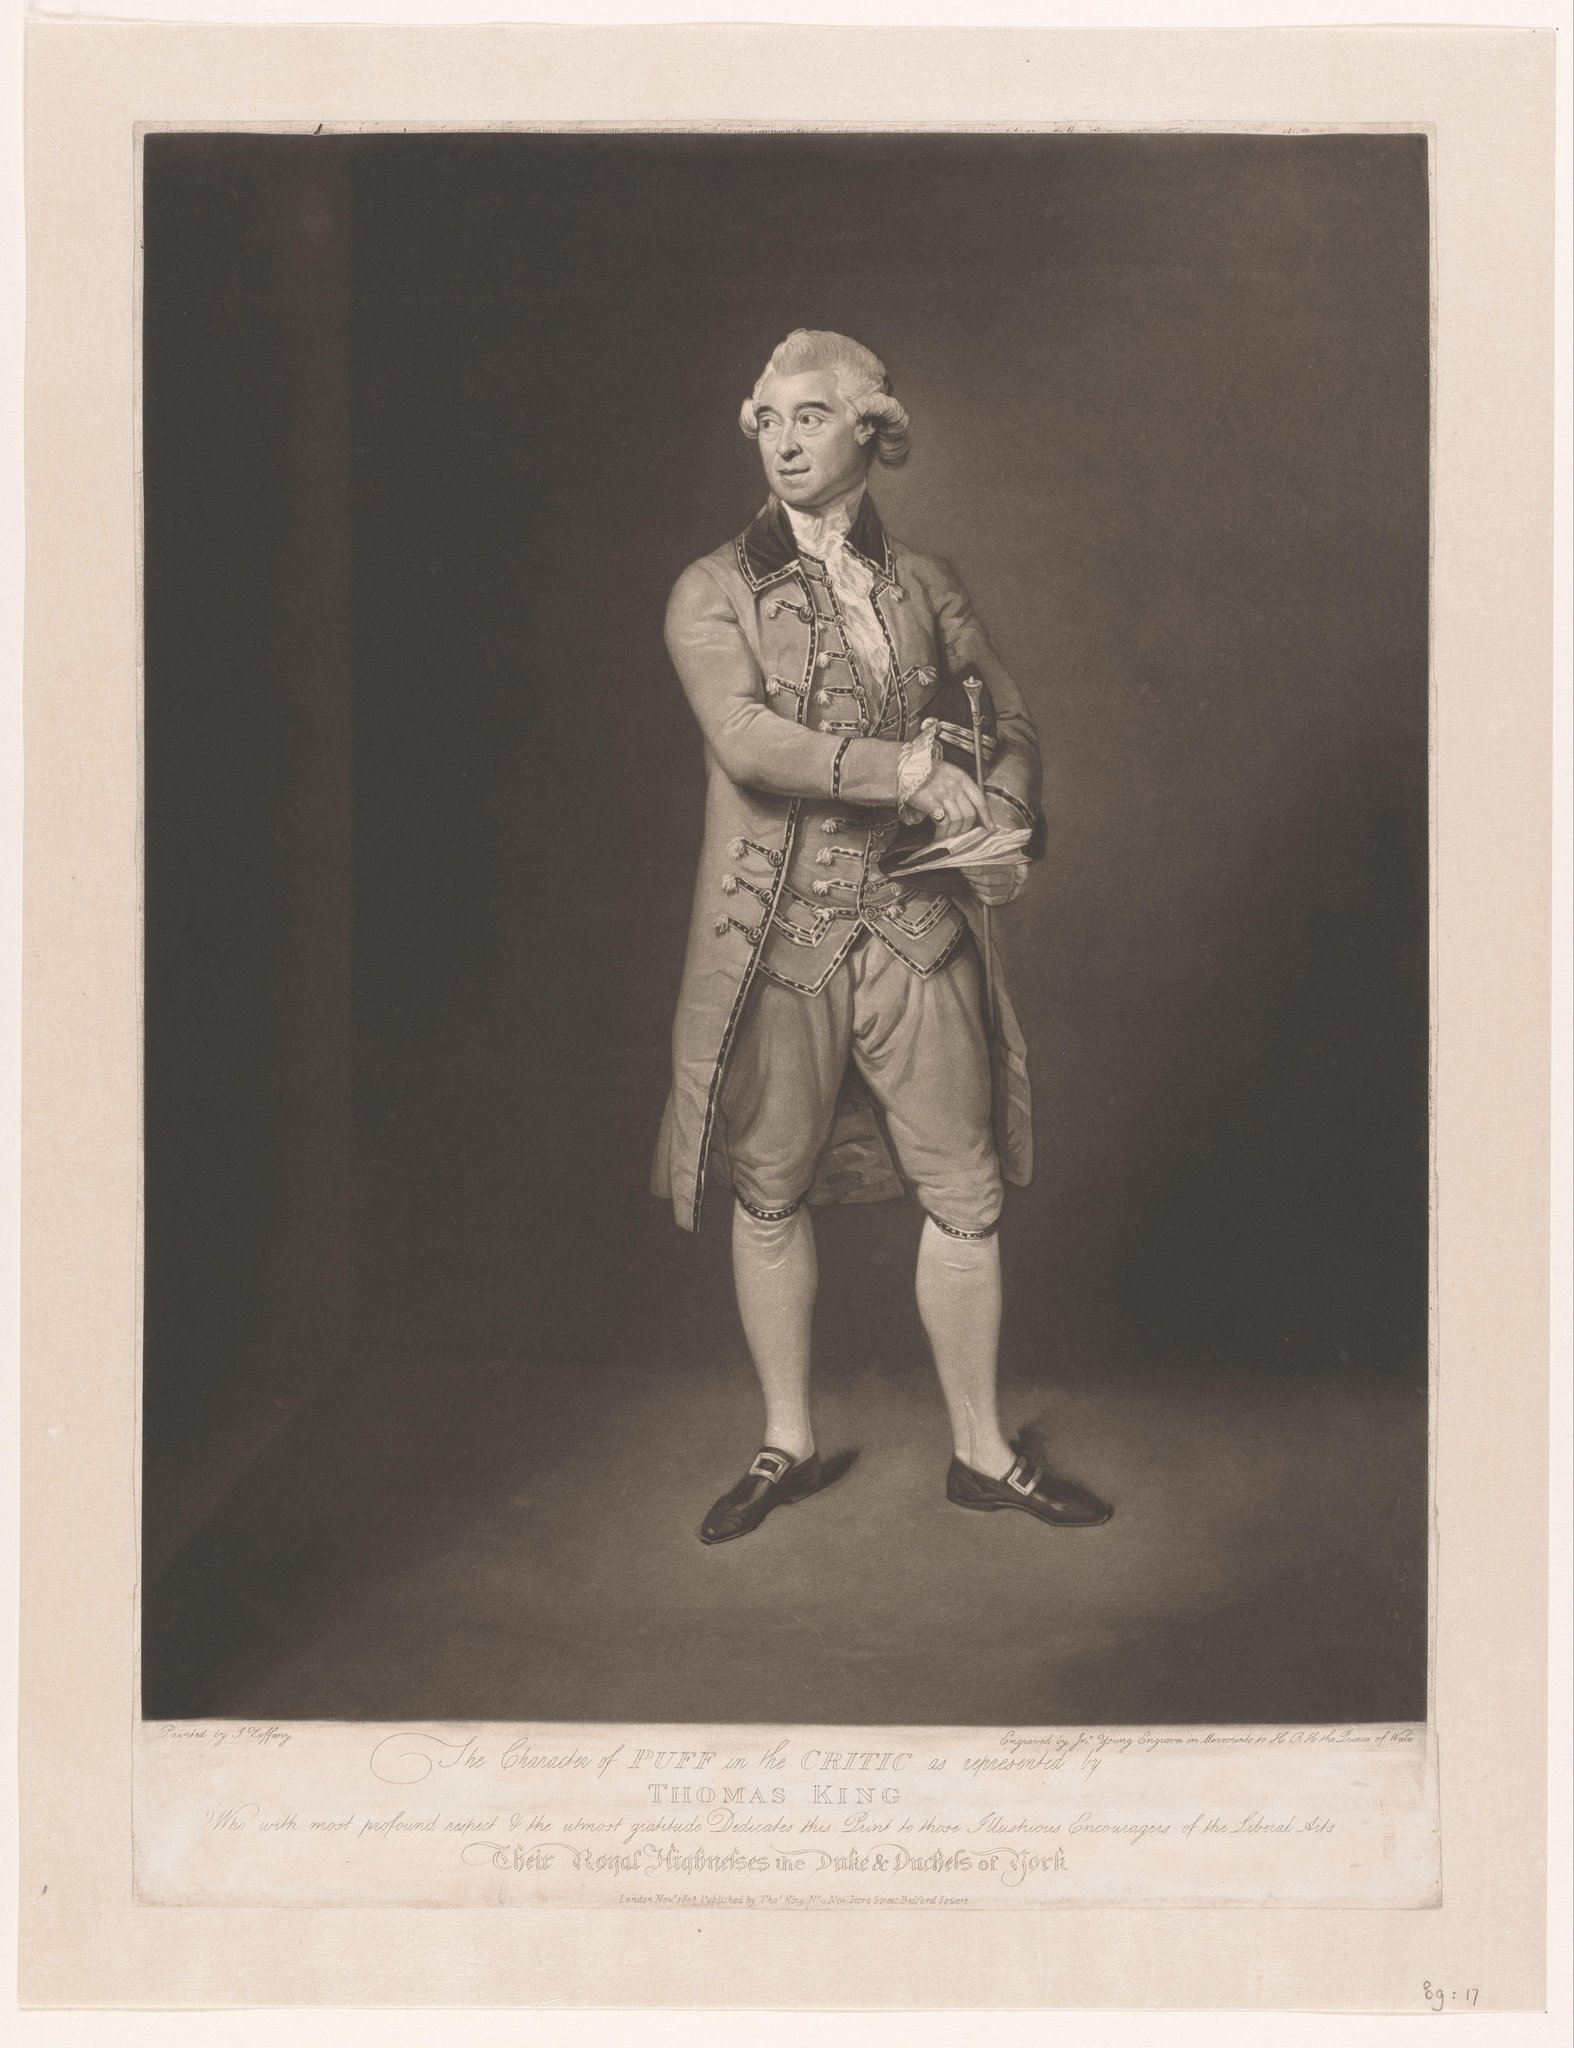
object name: print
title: Portret van Thomas King als Peter Puff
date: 1803-1811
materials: paper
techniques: mezzotint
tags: thomas king (acteur), portrait of actor, actress (+ artist at work), historical persons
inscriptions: collector's mark: Lugt 2760, collector's mark: Lugt 2228